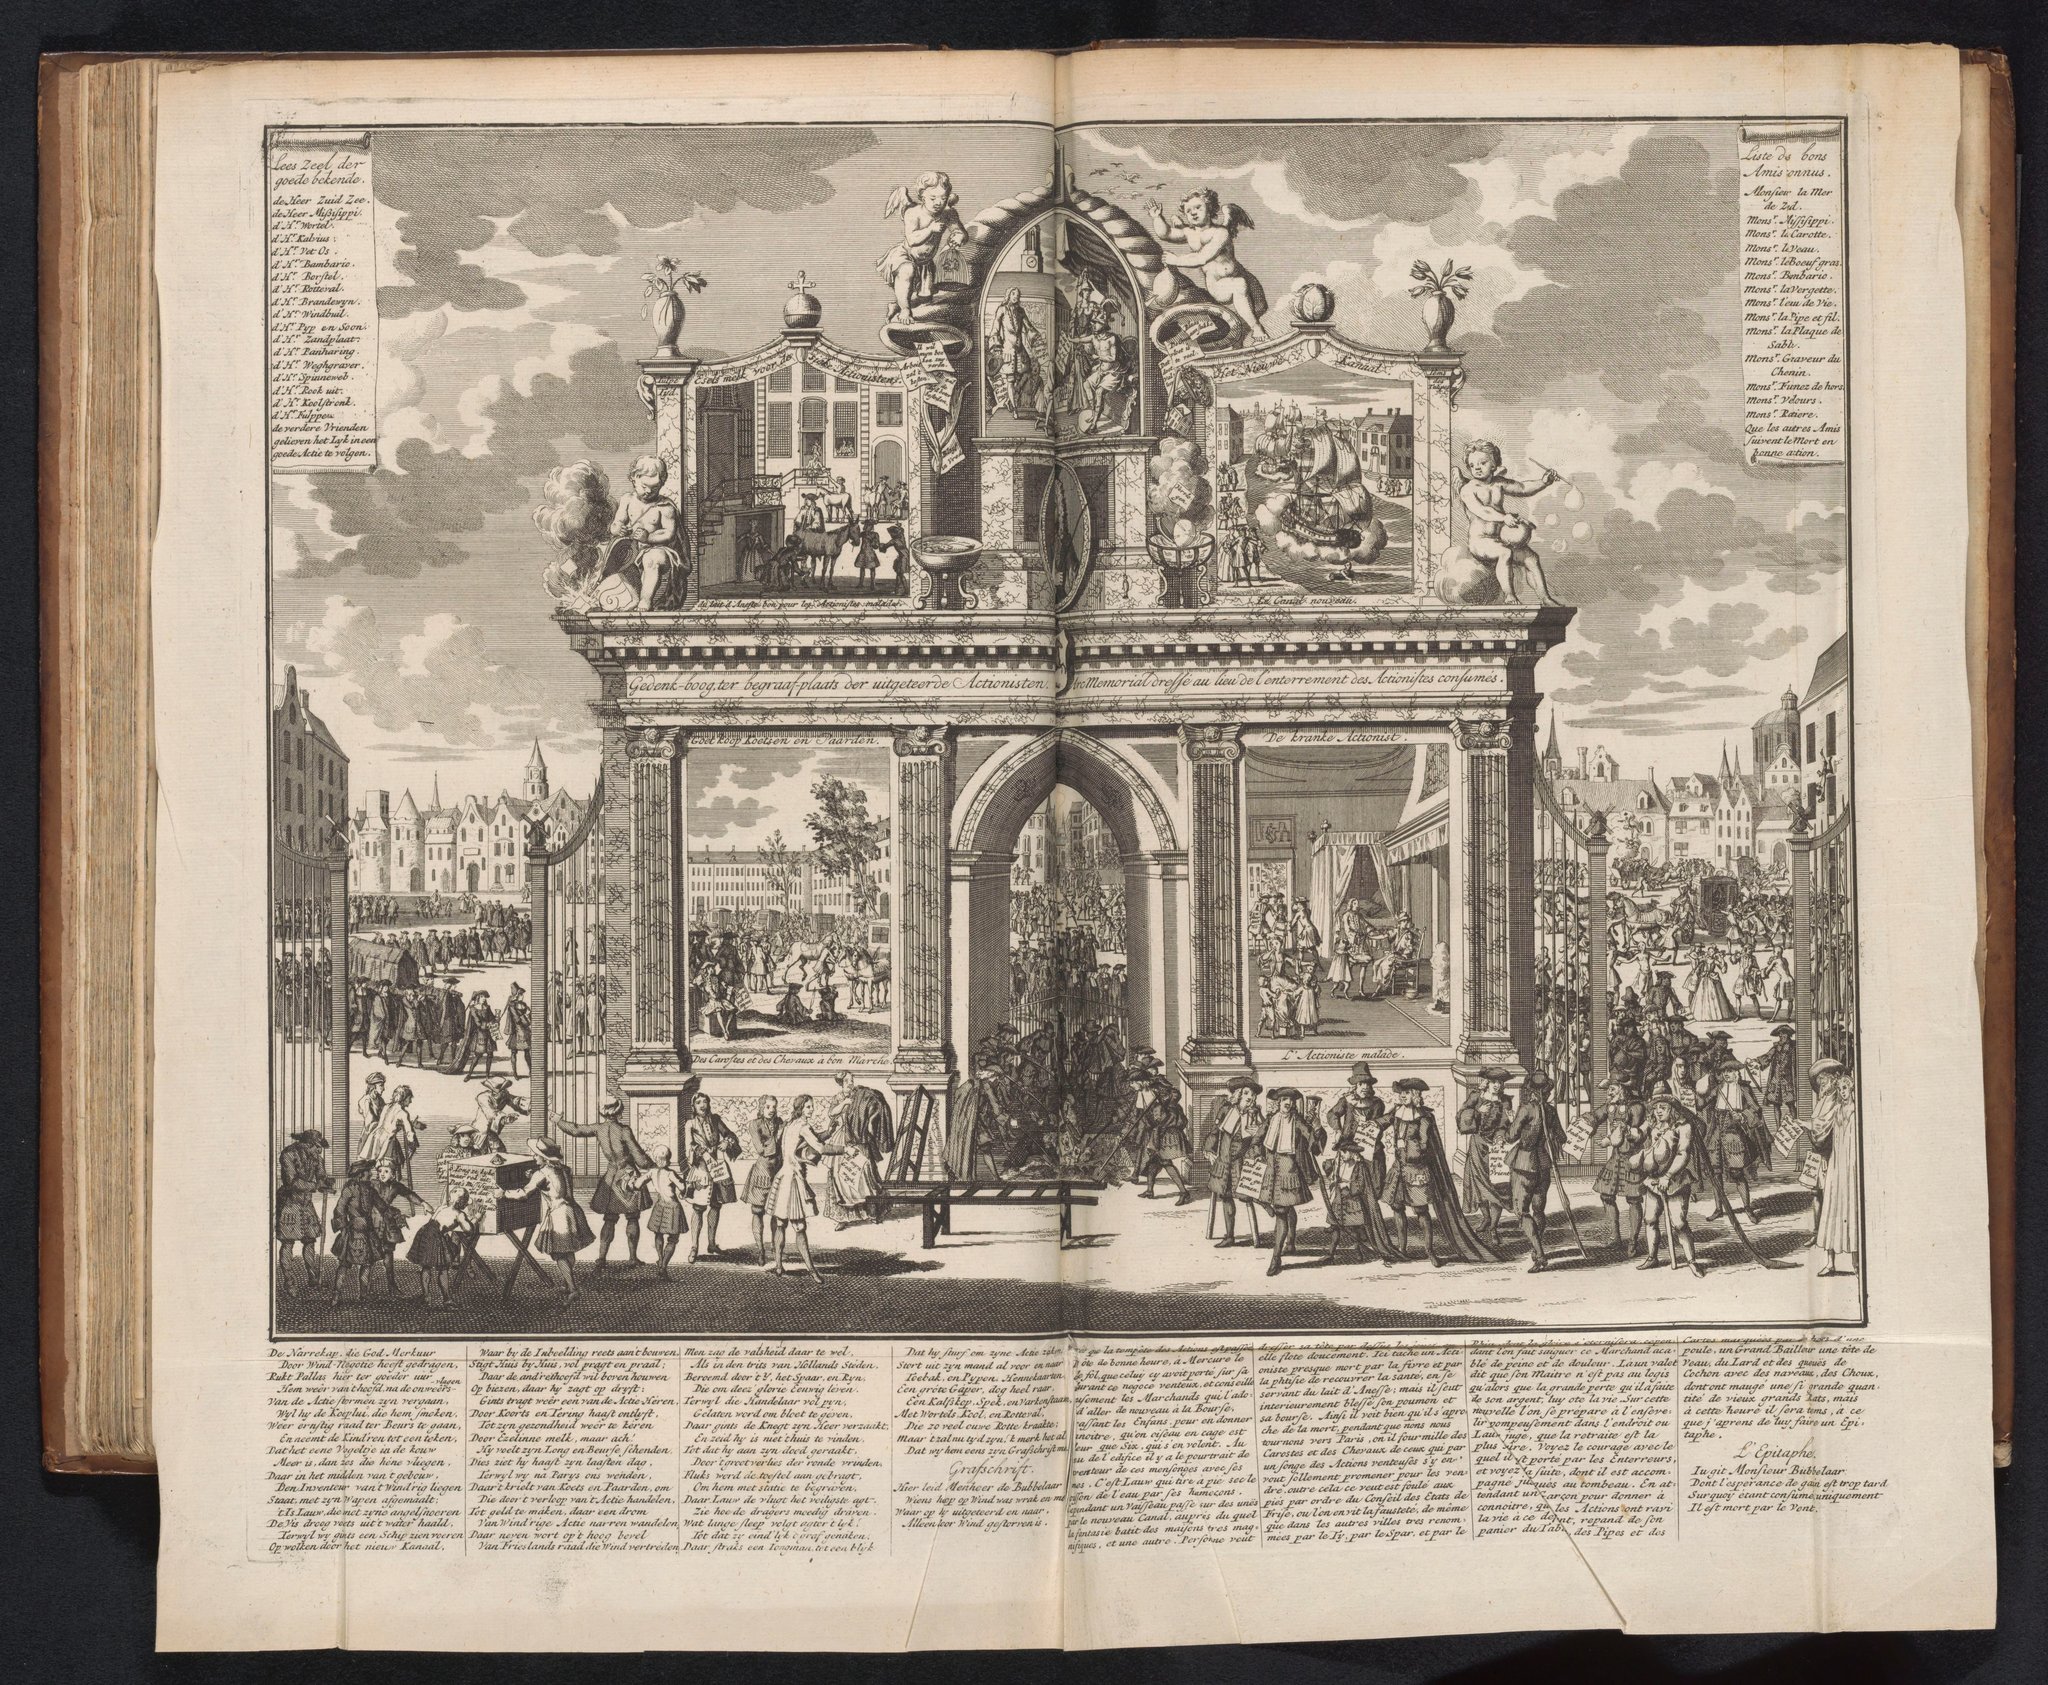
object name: print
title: Het Groote Tafereel der Dwaasheid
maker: Anonymous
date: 1720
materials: paper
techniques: etching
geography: northern netherlands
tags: triumphal arch, cortege, funeral procession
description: Stadsplein met een grote erepoort opgericht bij het overlijden en de begrafenis van de uitgeteerde Actionisten. In het midden wordt een graf gevuld met de waardeloze aandelen, van links komt een begrafenisstoet aangelopen. In de vakken op de ereboog staan voorstellingen van het ziekbed van de Actionist, John Law, het Utrechtse kanaal etc. Linksvoor een man met een kijkkast met de Mississippi en de Zuid. Met onderschrift in 8 kolommen in het Nederlands en Frans eindigend met het grafschrift van: Menheer de Bubbelaar. Prent in de gebonden eerste uitgave (304 B 11) van Het Groote Tafereel der Dwaasheid met spotprenten op de Windhandel of Actiehandel van 1720.